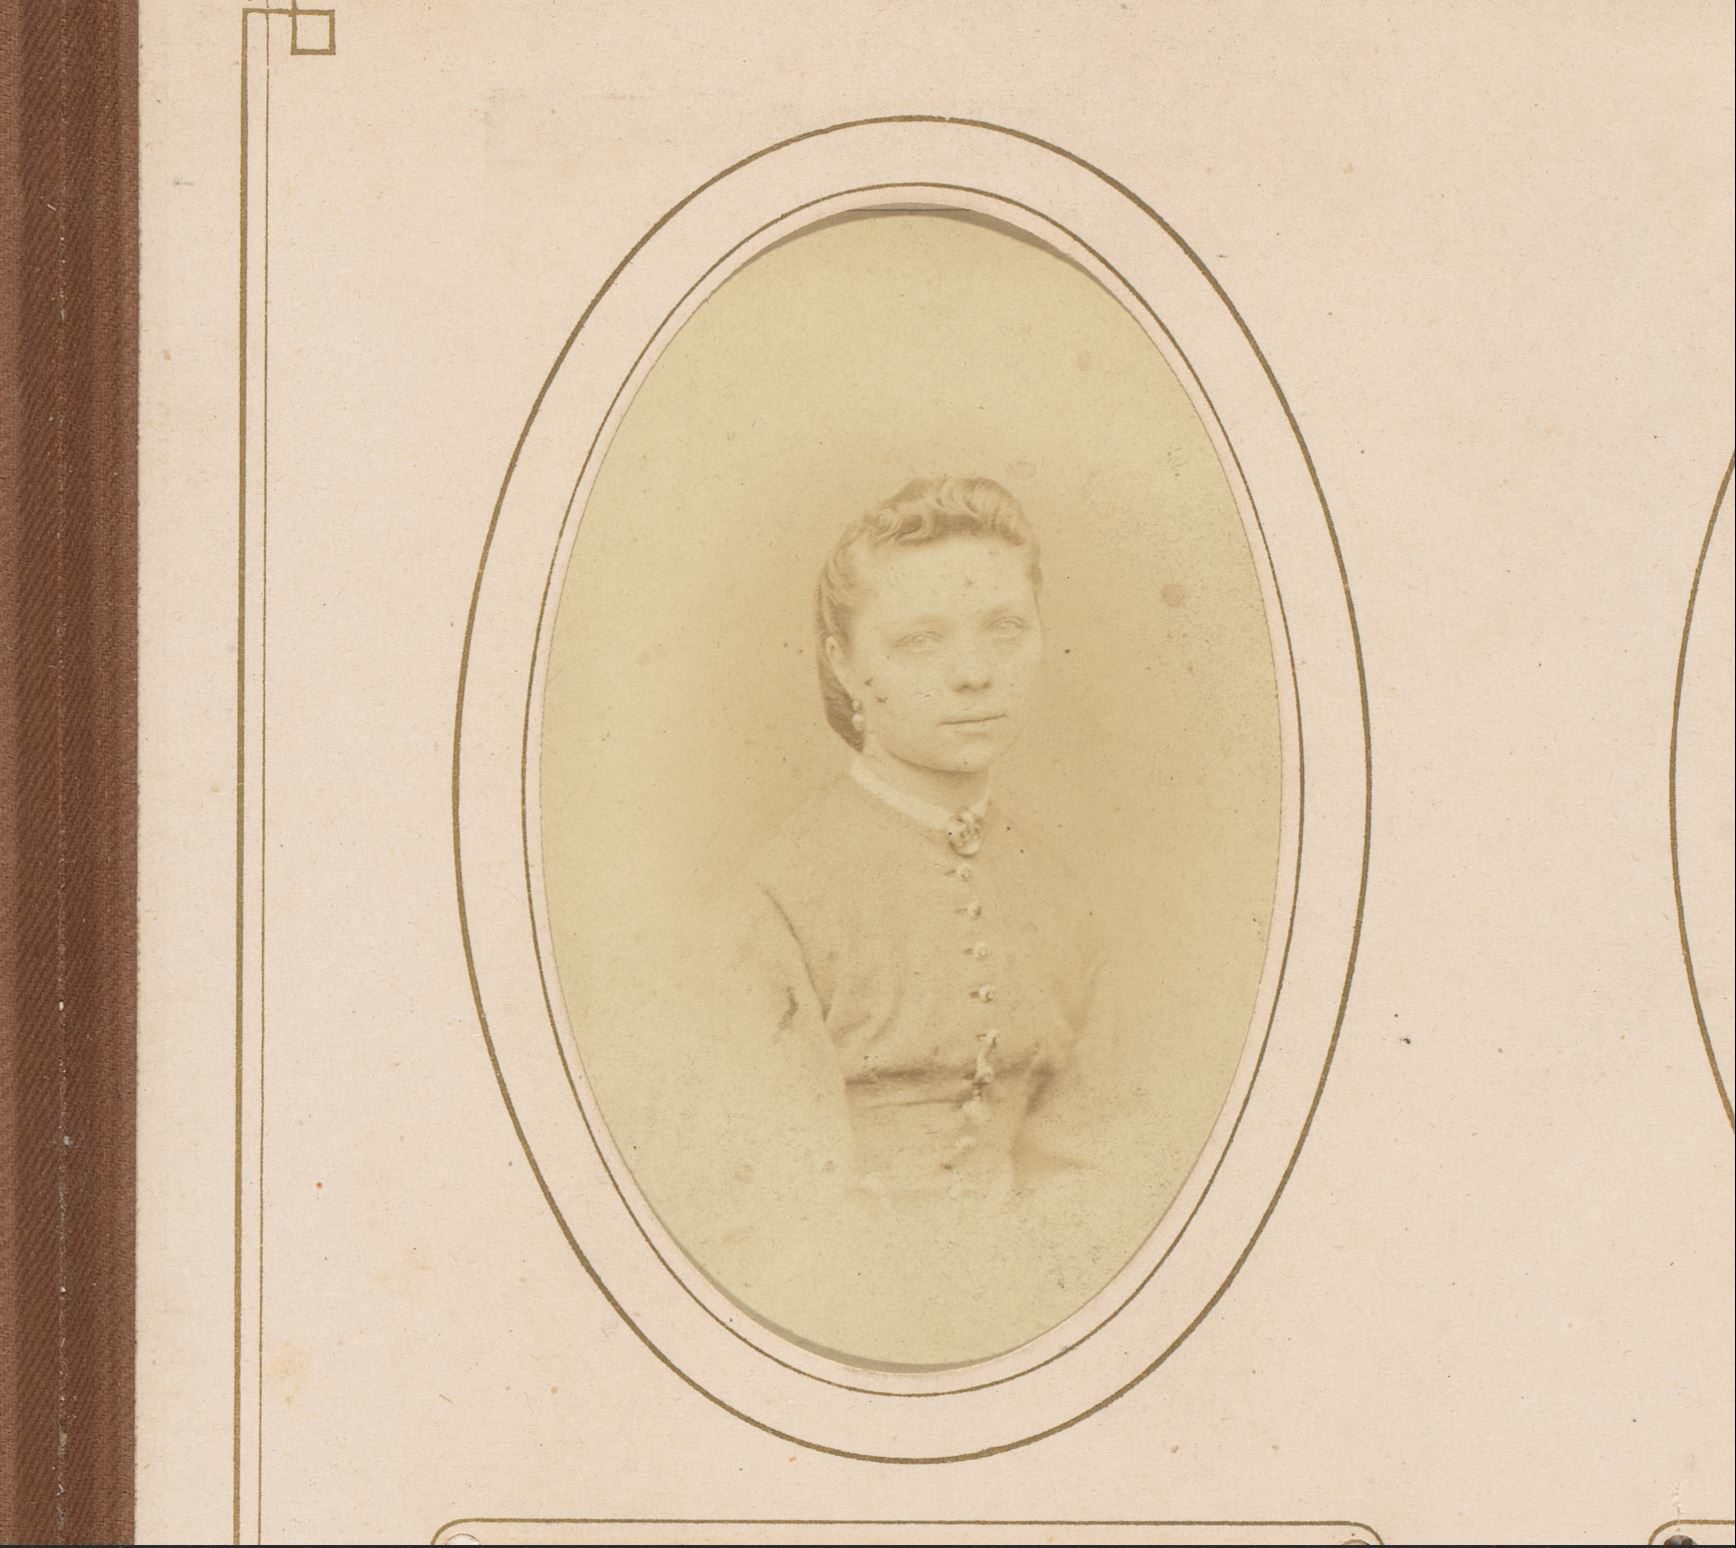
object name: photograph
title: Portret van jonge vrouw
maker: albert greiner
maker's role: fotograaf, fotostudio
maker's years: 1833-1890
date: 1861-1874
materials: cardboard, photographic support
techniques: albumen print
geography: amsterdam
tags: adolescent, young woman, maiden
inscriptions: inscription: ‘A. Greiner/ Photograf/ Nieuwendijk L.87/ Amsterdam’